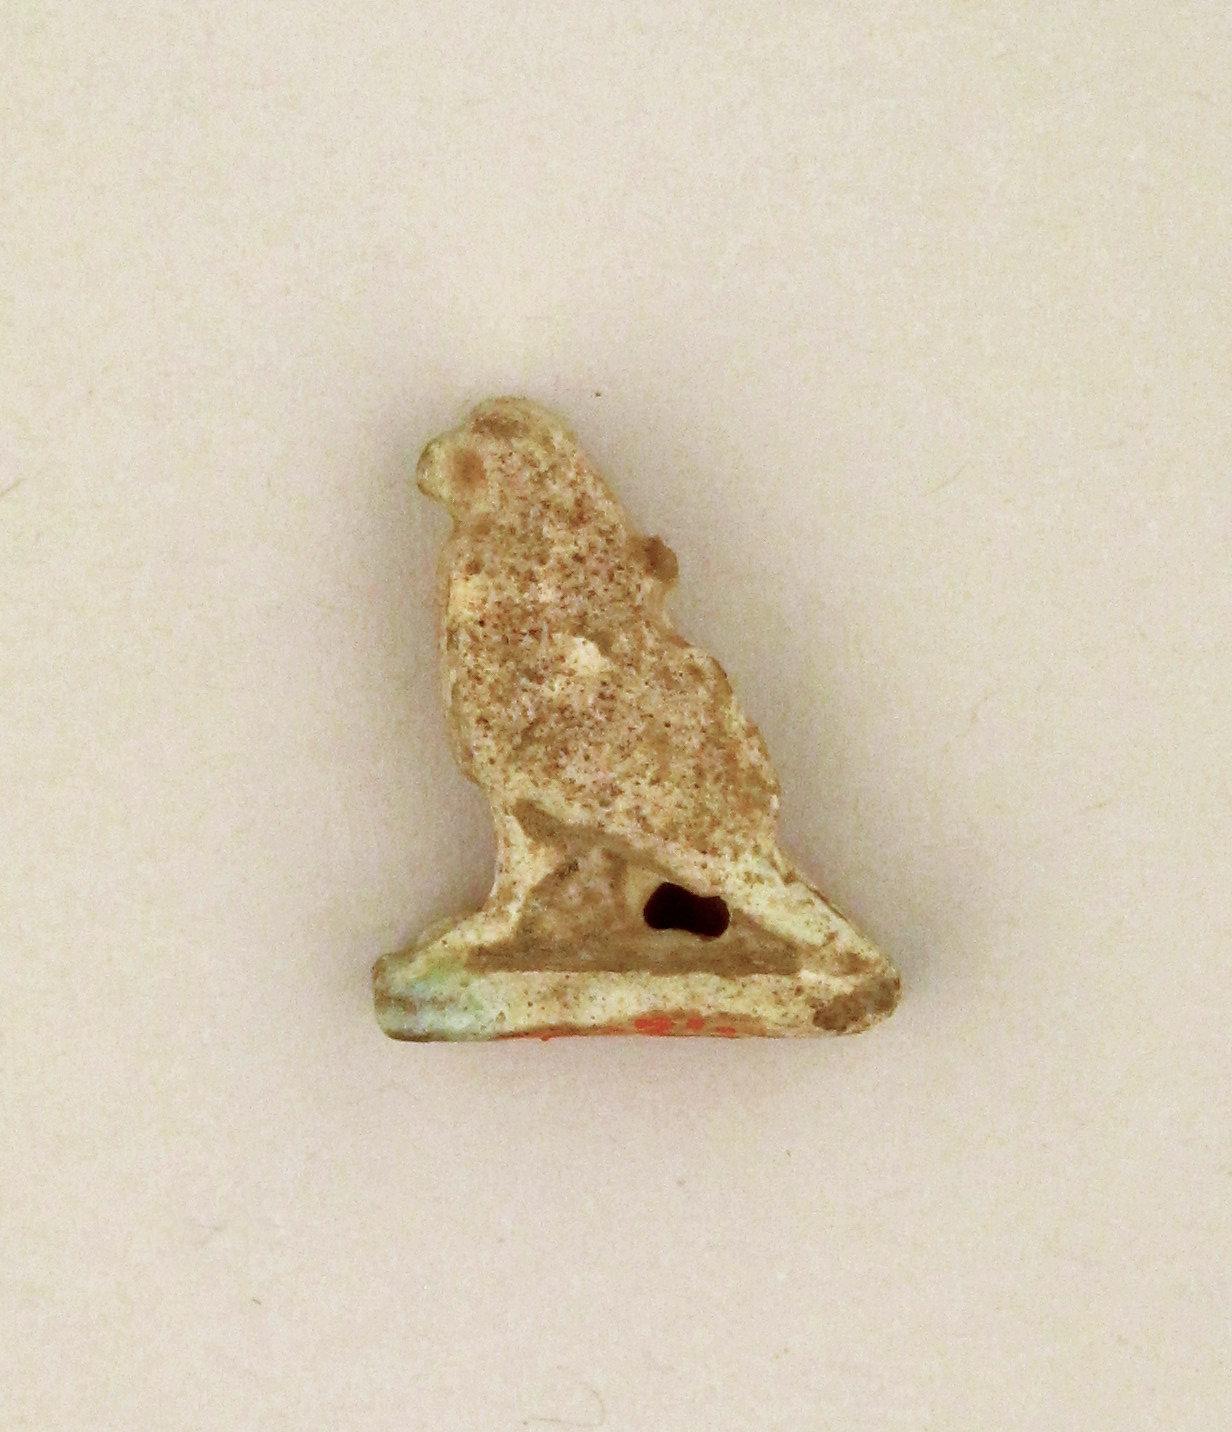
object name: amulet, falcon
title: Faience amulet of a falcon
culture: egyptian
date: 664-630 BCE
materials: faience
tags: falcons